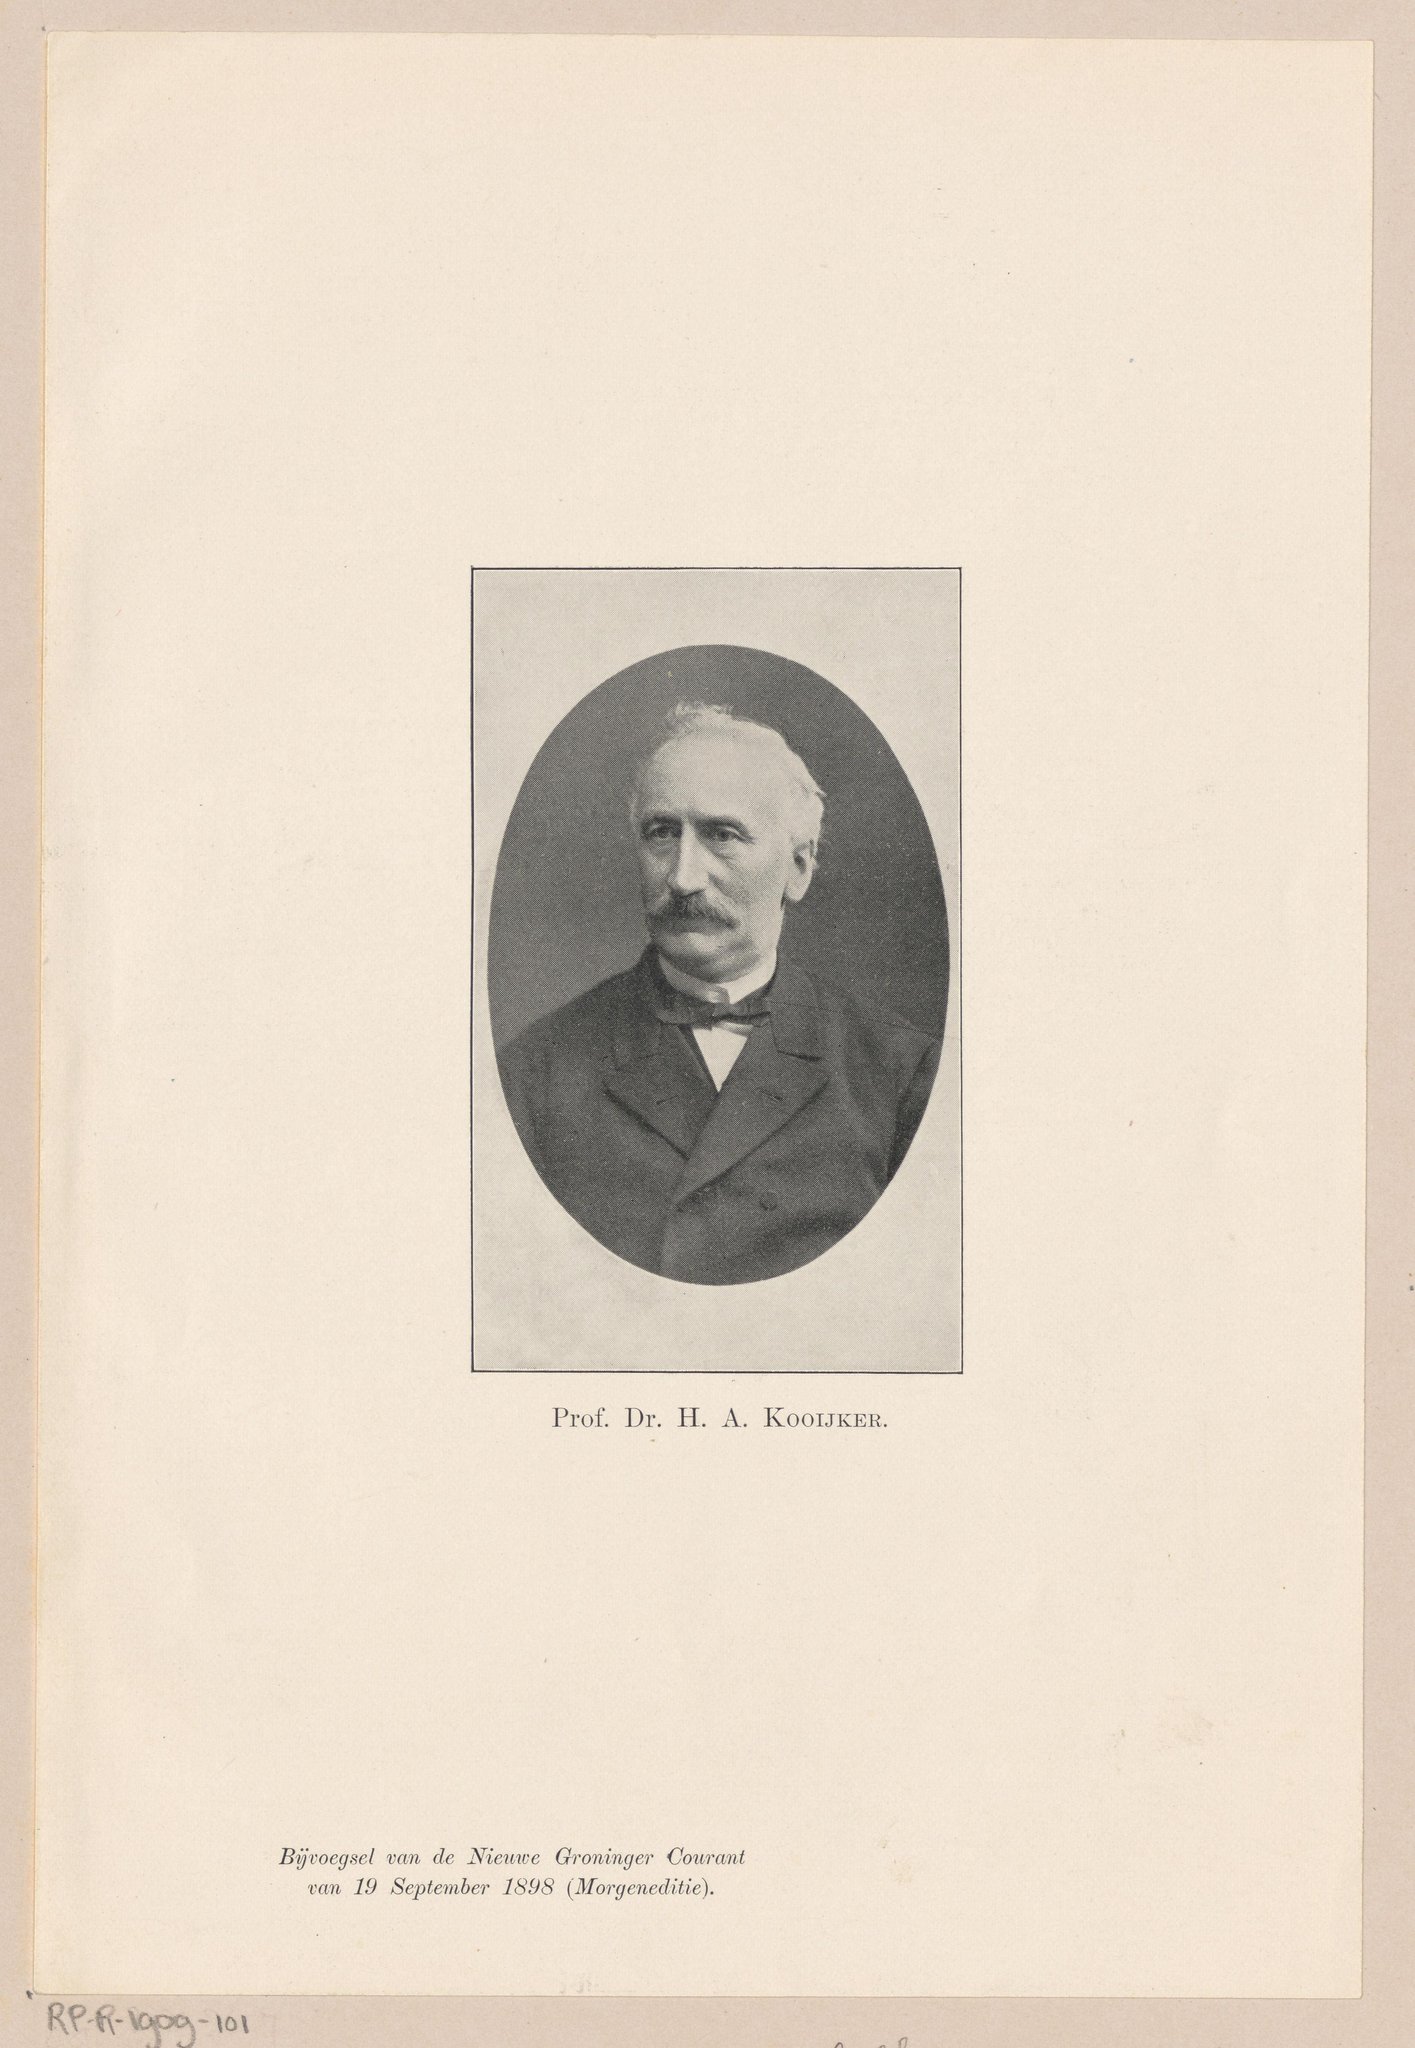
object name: photomechanical print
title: Portret van Hendrik Albert Kooyker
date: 1898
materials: paper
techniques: letterpress printing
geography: groningen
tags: amsterdam, historical persons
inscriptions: collector's mark: Lugt 2228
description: Prent uit het bijvoegsel van: De Nieuwe Groninger Courant, 19 september 1898.